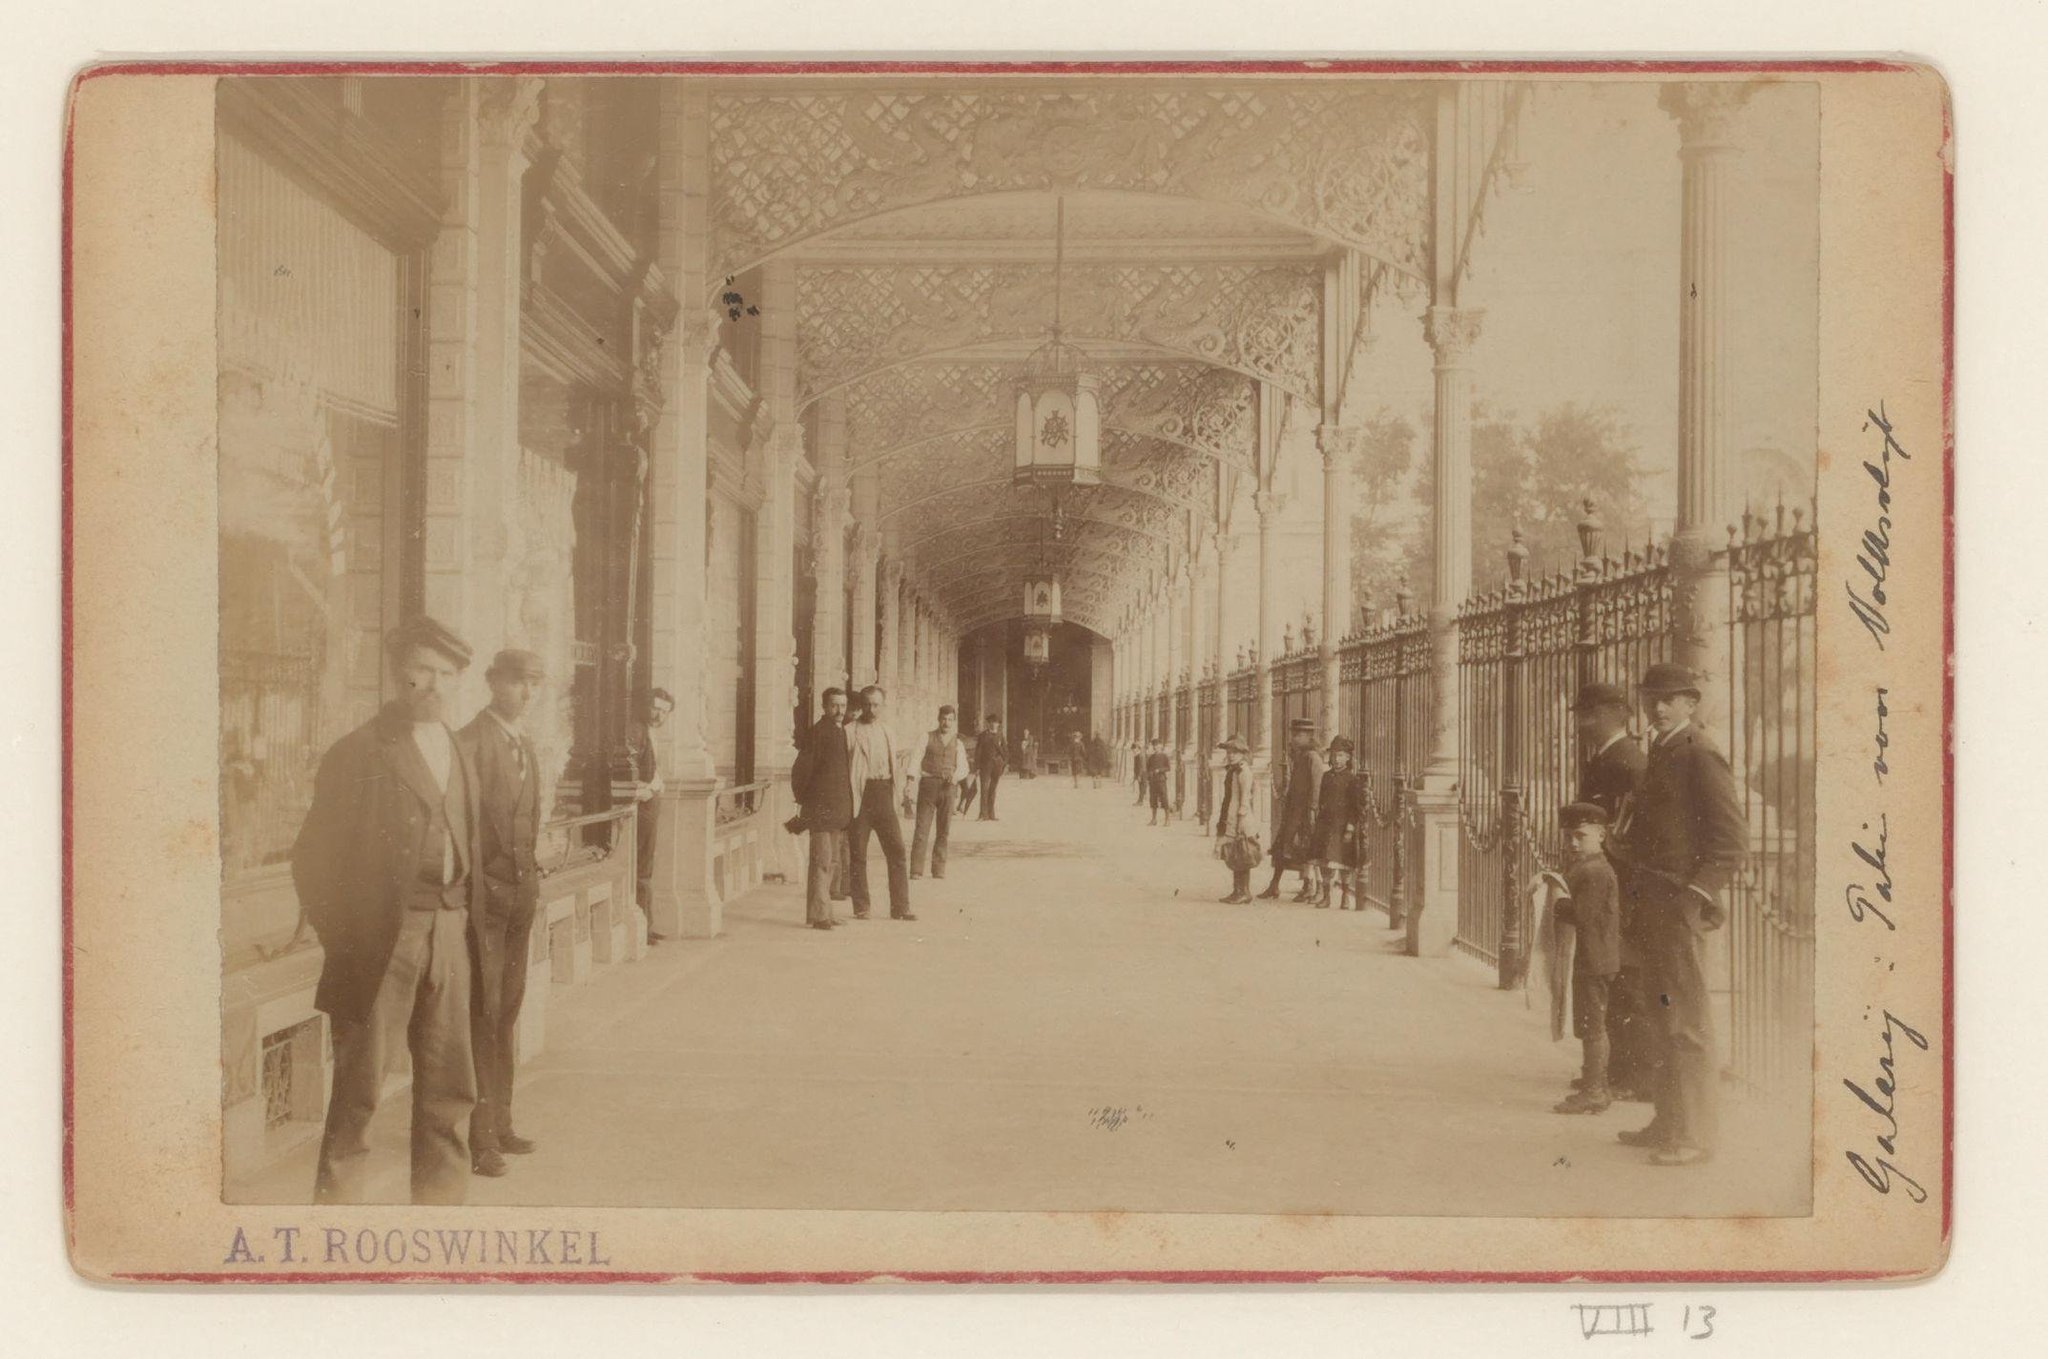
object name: cabinet photograph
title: Gezicht op de binnenkant van de galerij van het Paleis voor Volksvlijt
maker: andreas theodorus rooswinkel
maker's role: fotograaf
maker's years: 1838-1909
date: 1864-1909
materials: cardboard, paper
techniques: albumen print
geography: amsterdam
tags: city-view in general; 'veduta', gallery (spacious corridor)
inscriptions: inscription: ‘Galerij: Paleis voor Volksvlijt’, collector's mark: ‘8’ Lugt 1641b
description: Onderwerpsrubriek binnen de Atlas Amsterdam: Galerij Paleis voor Volksvlijt, Gebed zonder end, Geldersche Kade, Gravenstraat, Grimburgwal, Grimnessesluis, Groeneburgwal.